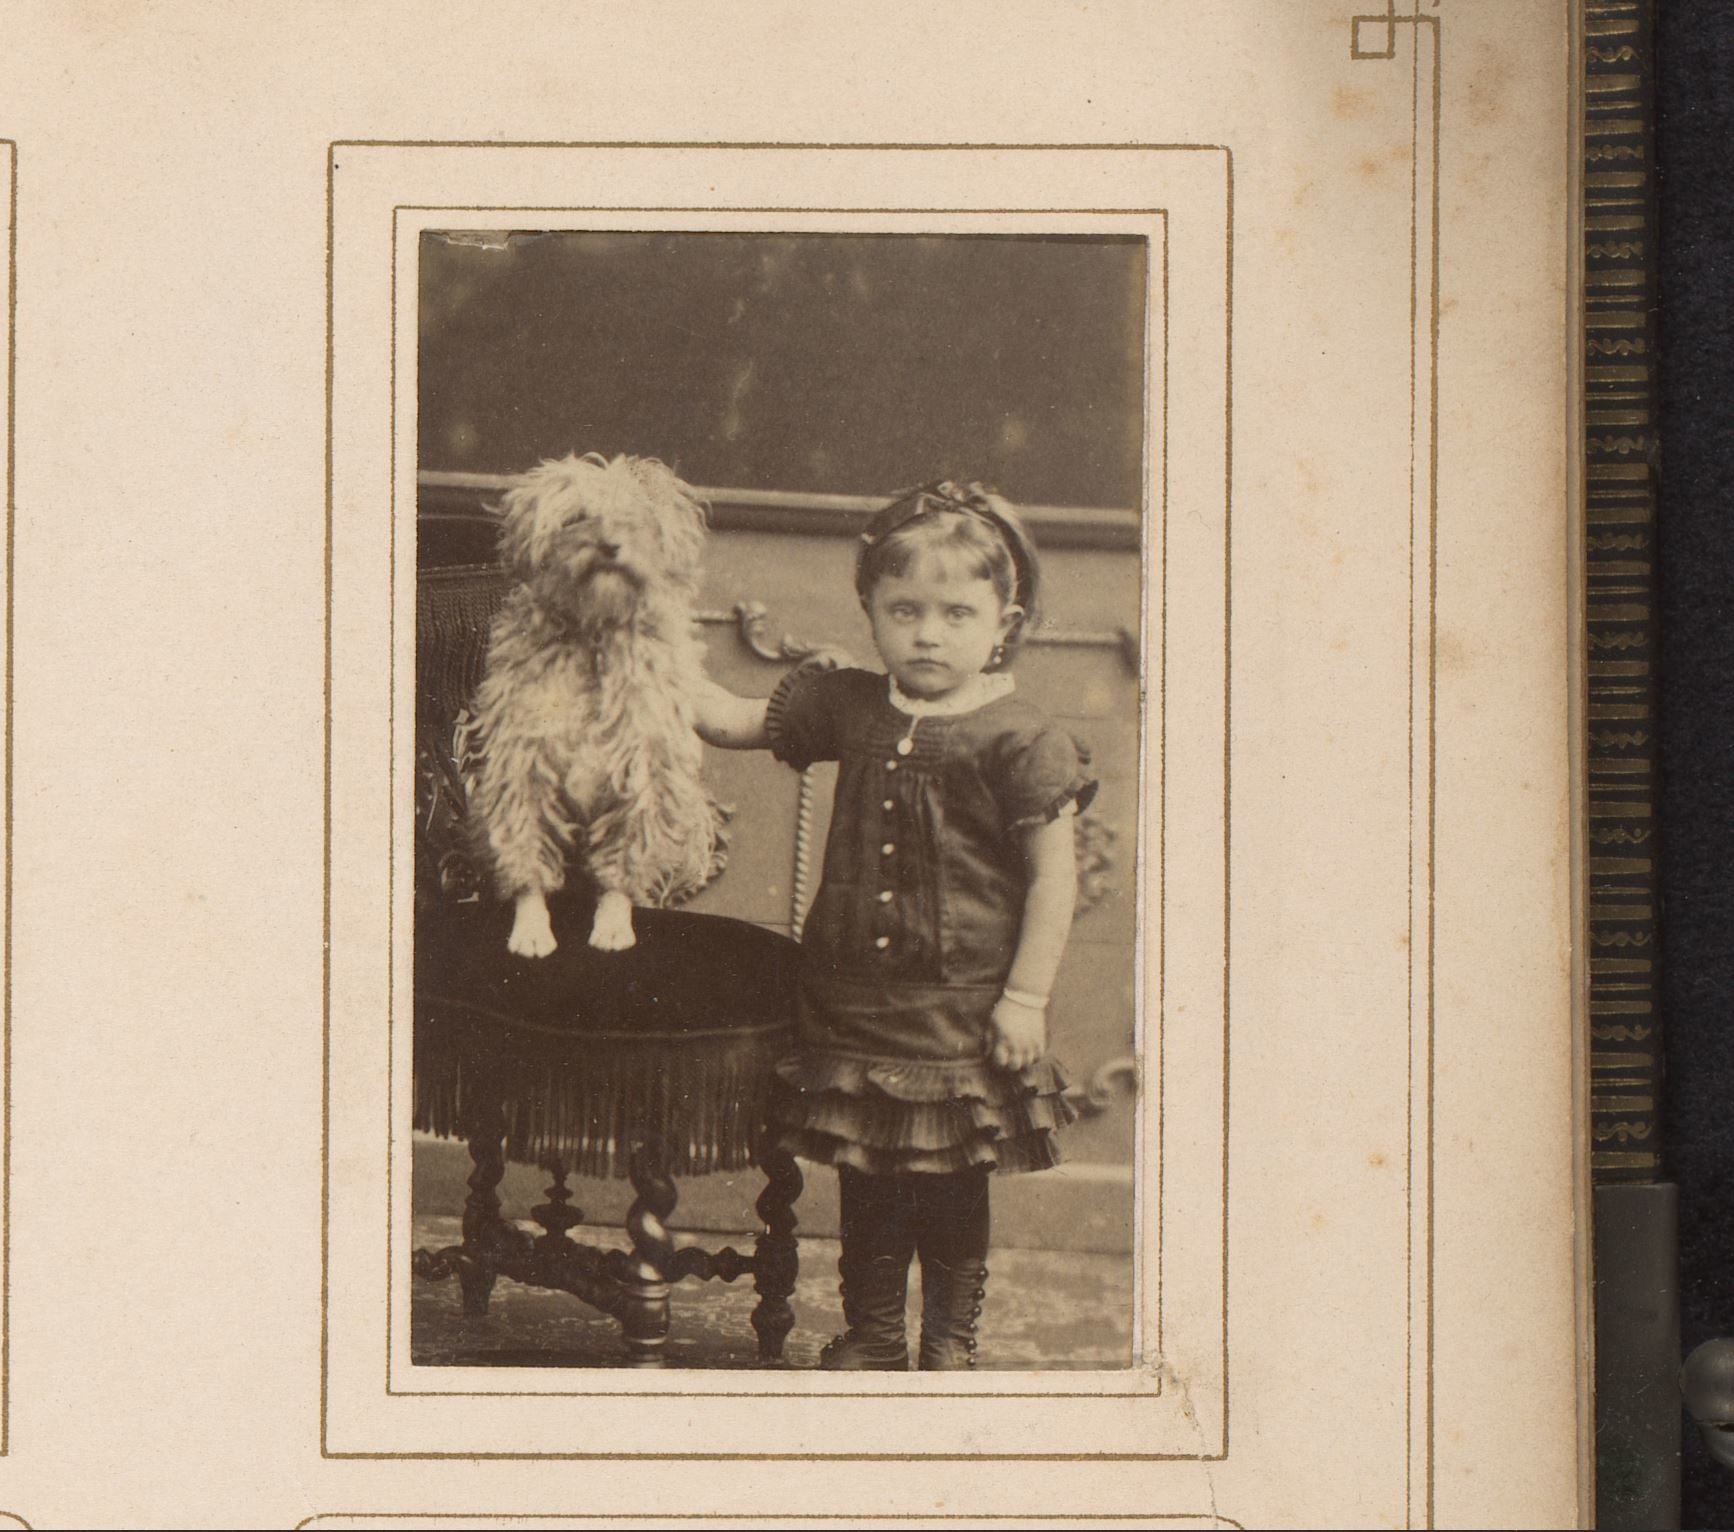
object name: photograph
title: Portret van een meisje met hond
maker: frederik harting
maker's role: fotograaf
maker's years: 1835-1902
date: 1863-1899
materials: cardboard, photographic support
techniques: albumen print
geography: gouda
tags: girl (child between toddler and youth), dog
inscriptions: inscription: ‘Photographie Artistique/ F. Harting/ Gouda/ Oost-Haven B No. 14’